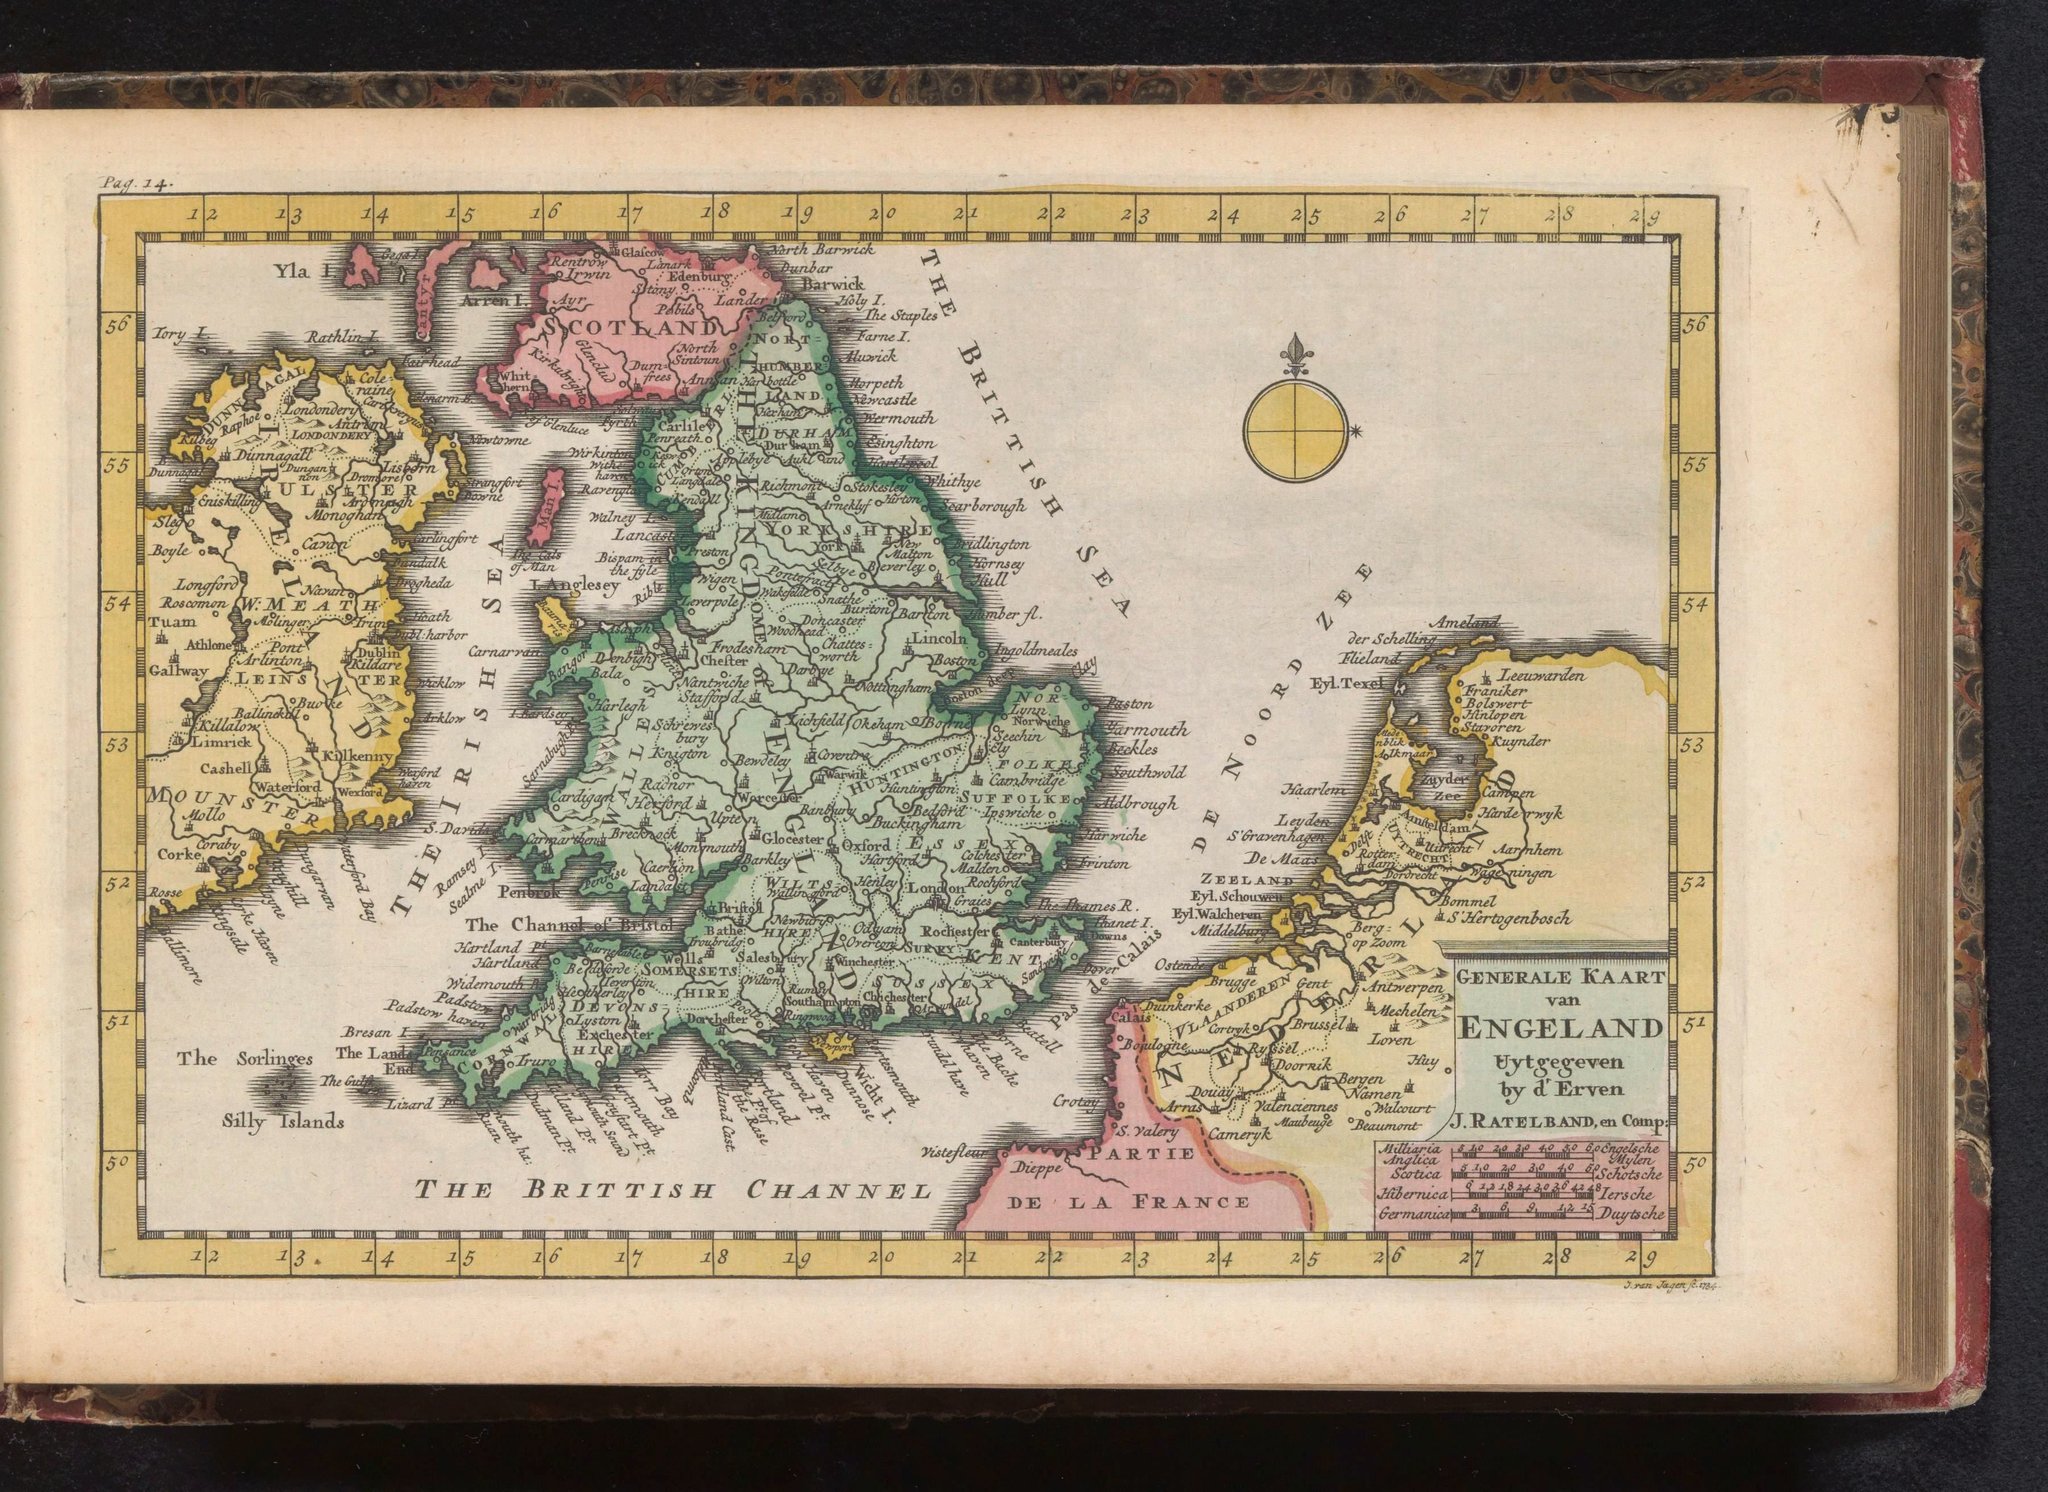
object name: print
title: Kaart van Engeland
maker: jan van jagen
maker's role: print maker, publisher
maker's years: 1709-1800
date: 1734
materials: paper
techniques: engraving, etching, hand coloring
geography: amsterdam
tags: maps of separate countries or regions, england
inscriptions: date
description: Kaart van Engeland, ook met delen van Ierland, Schotland en Nederland. Onderdeel van een atlas met 223 kaarten van landen en steden en oorlogstaferelen in Europa in de periode ca. 1690-1735.